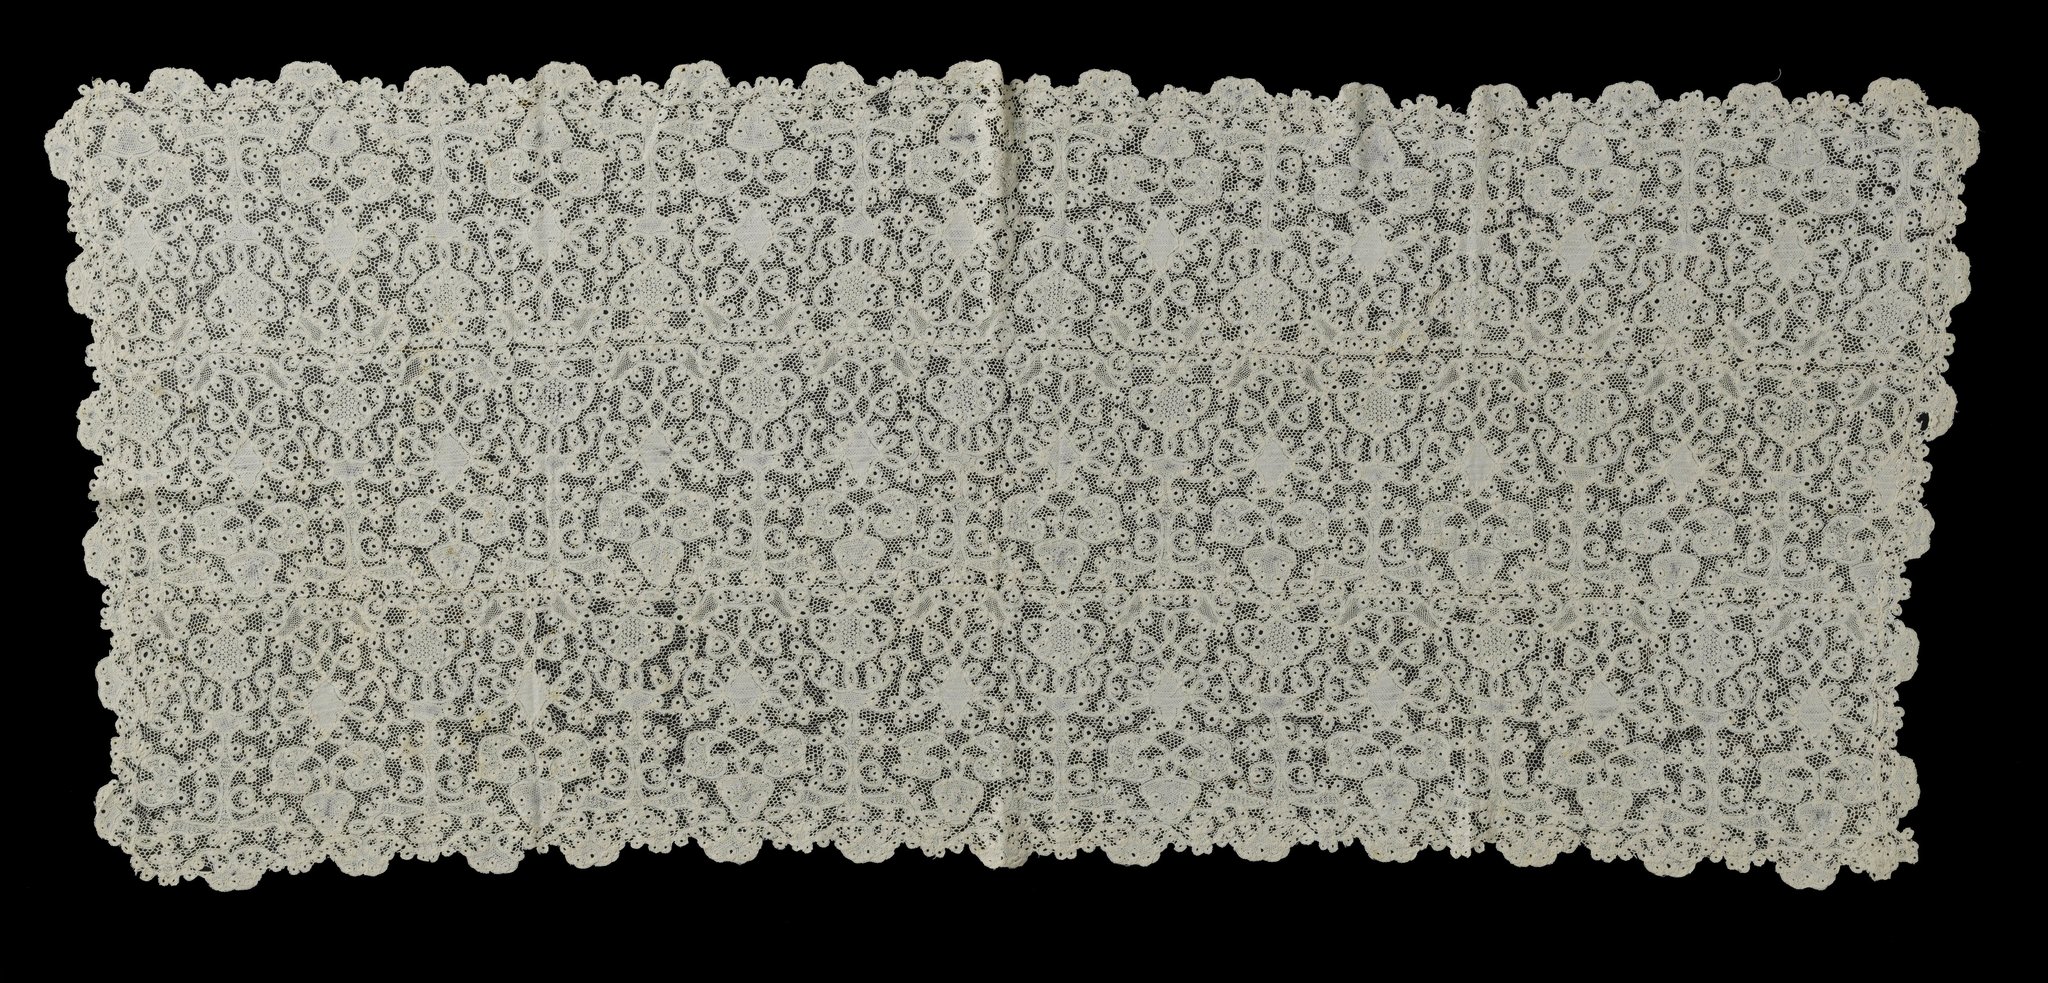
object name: kleed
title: Kleed van drie stroken kloskant met symmetrische kandelabermotieven die elkaar afwisselen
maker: Anonymous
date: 1700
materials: linen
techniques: lace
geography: southern netherlands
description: Kleed van naturelkleurig kloskant: lintkant. Het kleed bestaat uit drie onder elkaar genaaide stroken. Het zich herhalende en symmetrische patroon bestaat per strook uit twee kandelabermotieven die elkaar afwisselen. De motieven worden gevormd door lange smalle linten geklost in linnenslag met opengewerkte randjes. De linten vormen de contouren van de motieven en vele lussen. Binnen de contouren zijn verschillende siergronden toegepast, ten opzichte van de traliegrond dicht gewerkt met onder andere sneeuwvlokkengronden en linnenslag met zeer fijne uitsparingen. Schulpenrand rondom.